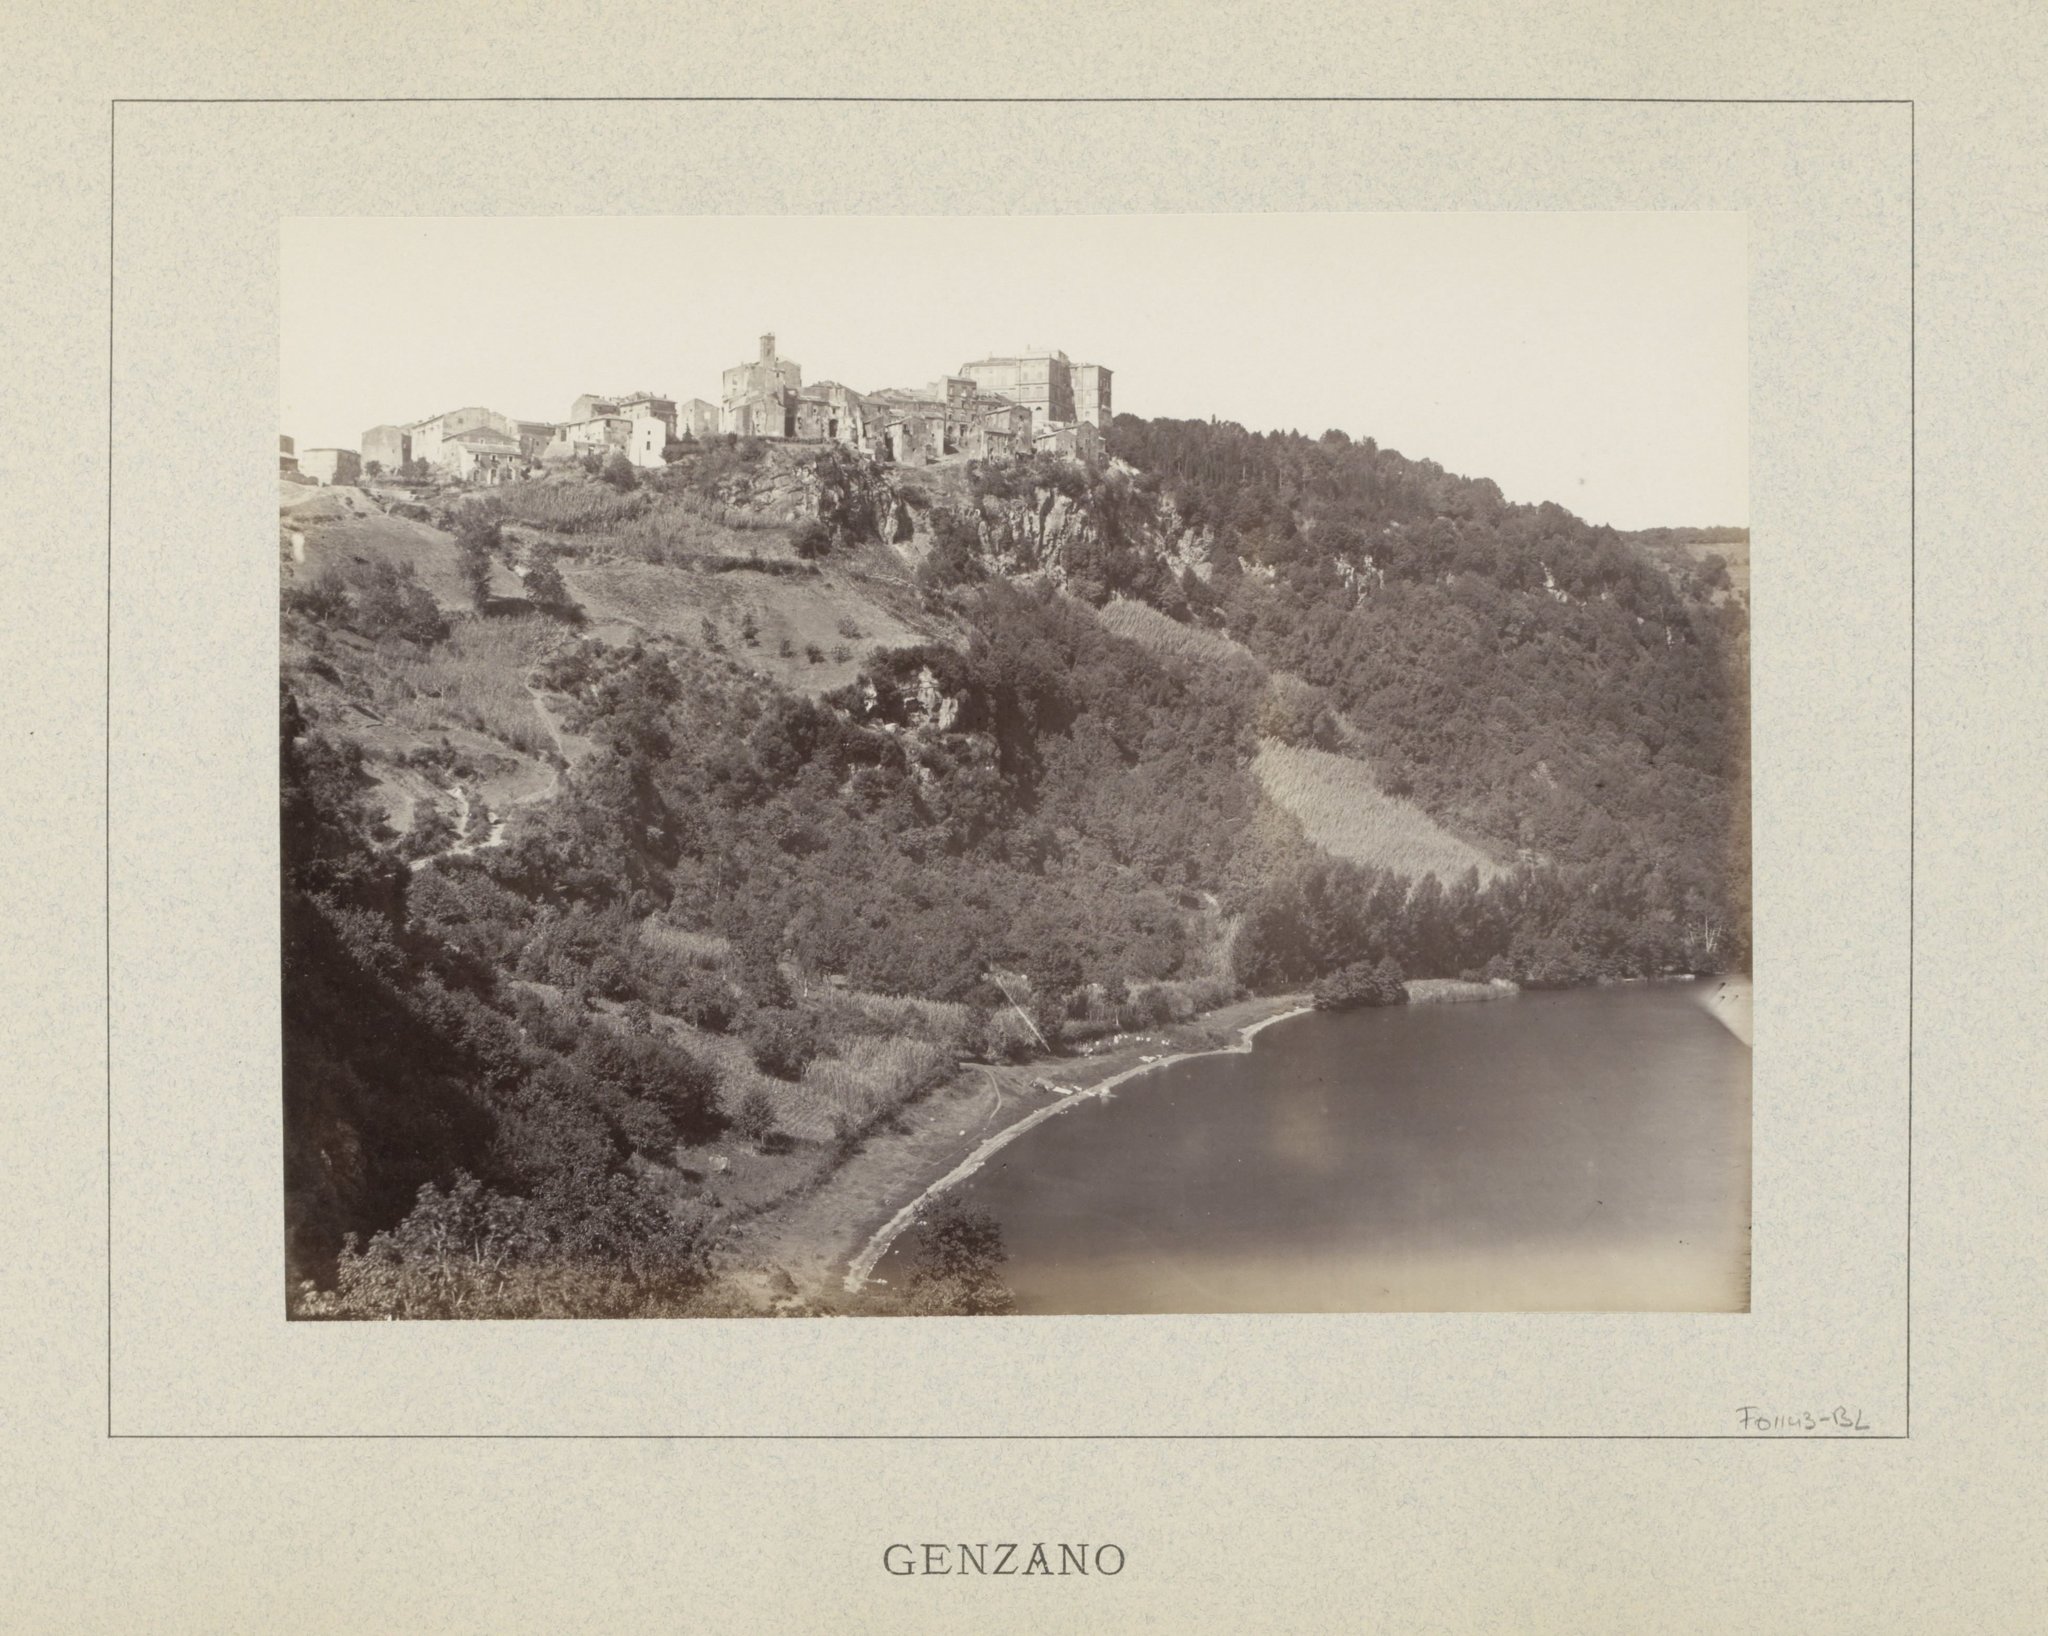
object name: photograph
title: Gezicht op Genzano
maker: Anonymous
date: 1860-1900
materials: photographic support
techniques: albumen print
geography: genzano di roma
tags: prospect of village, silhouette of village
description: Onderdeel van Fotoalbum met opnames van bezienswaardigheden en kunstwerken in Rome.